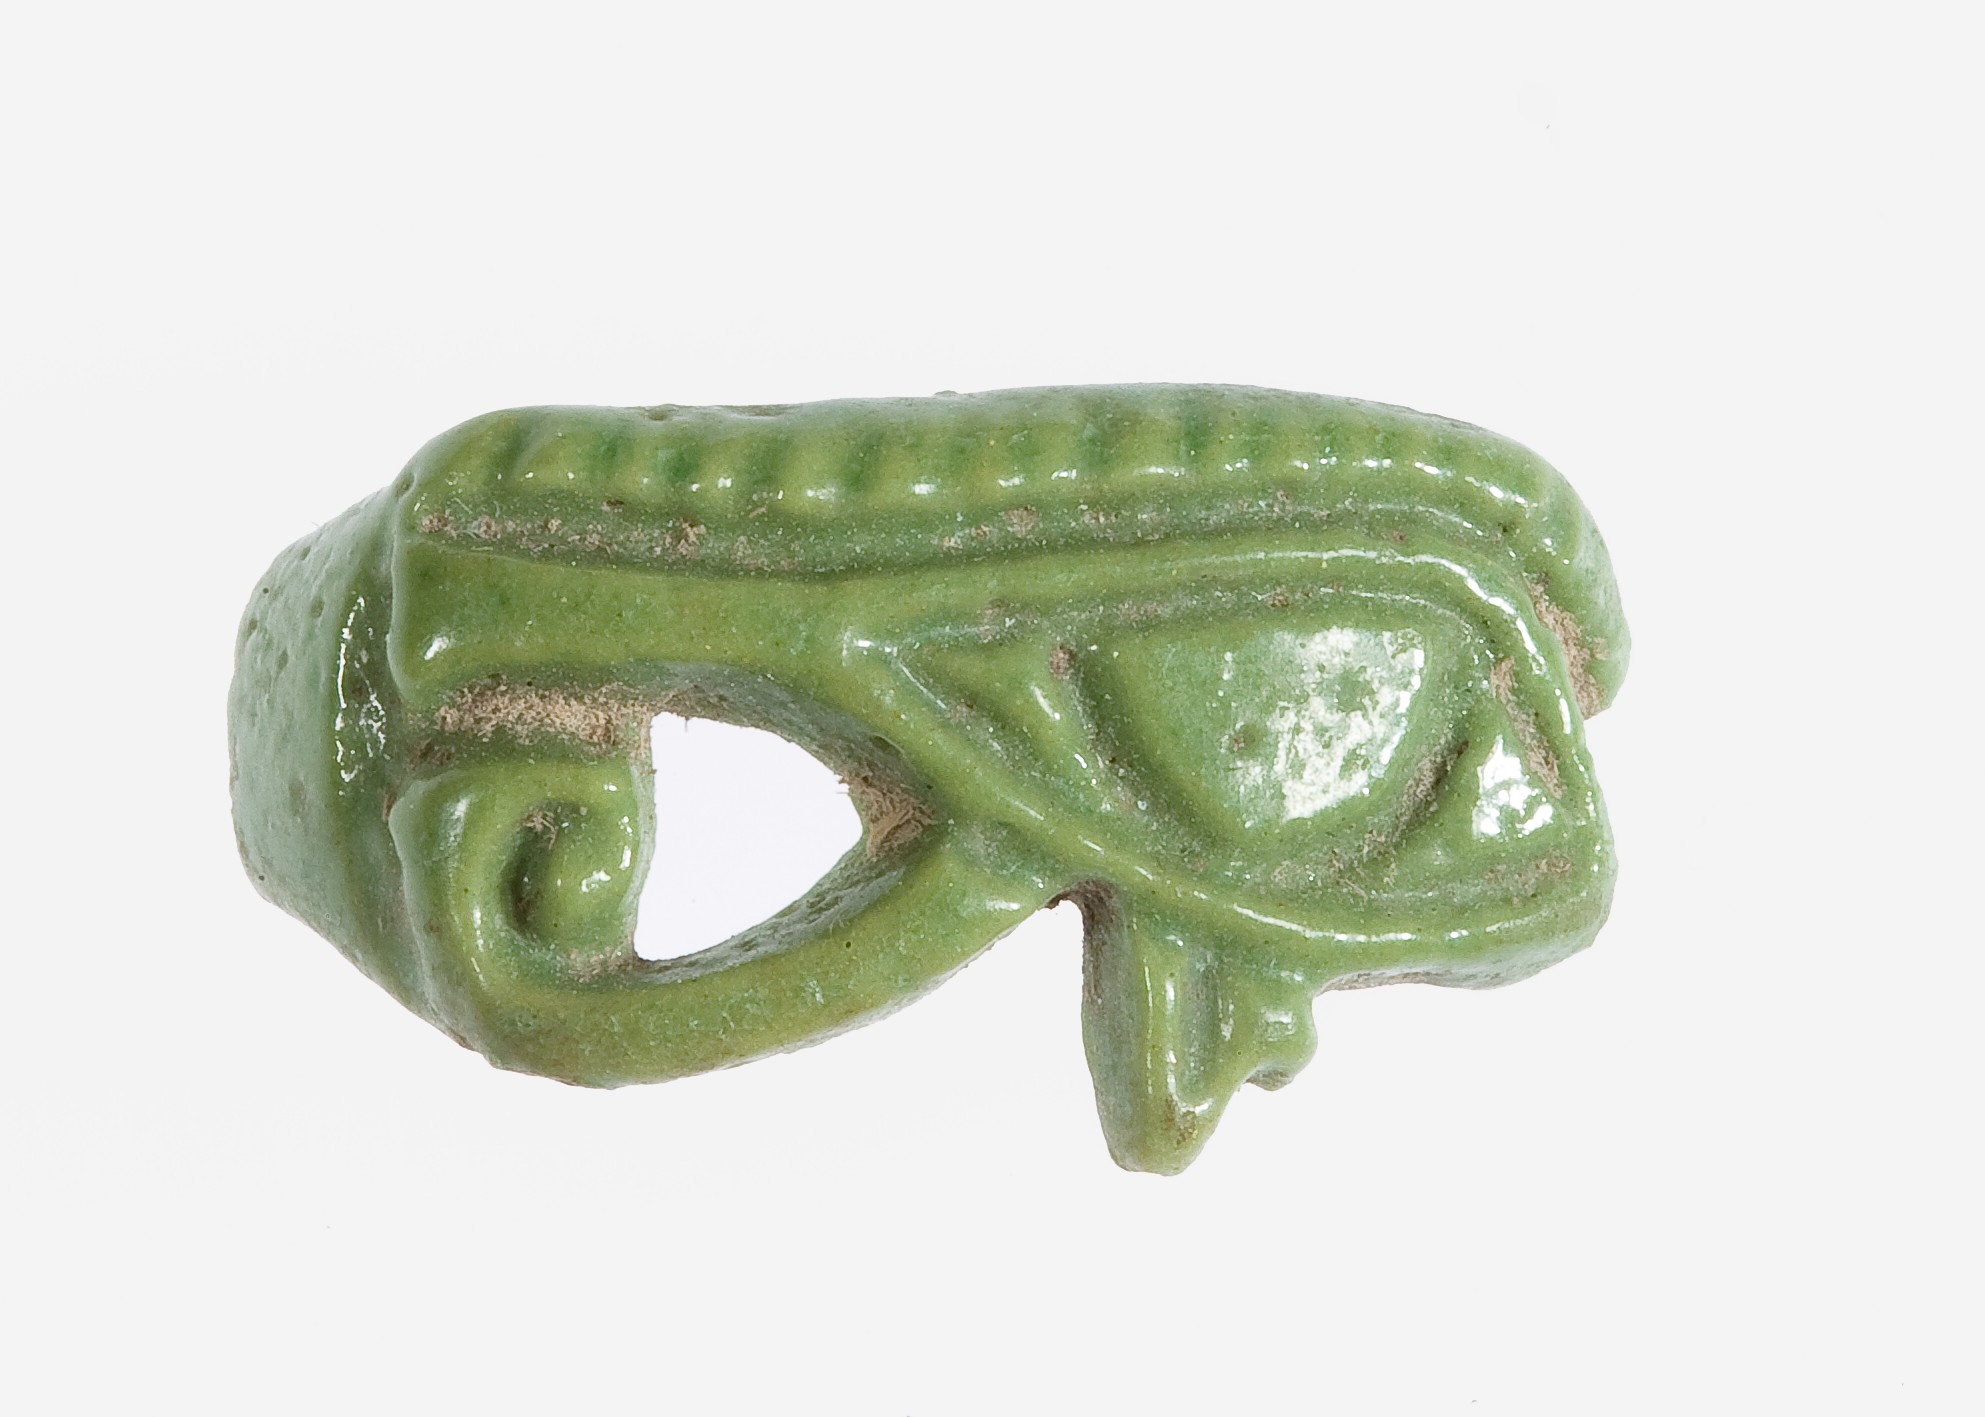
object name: ring, wedjat eye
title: Fragment of a Wedjat Eye Ring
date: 1390-1352 BCE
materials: faience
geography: egypt